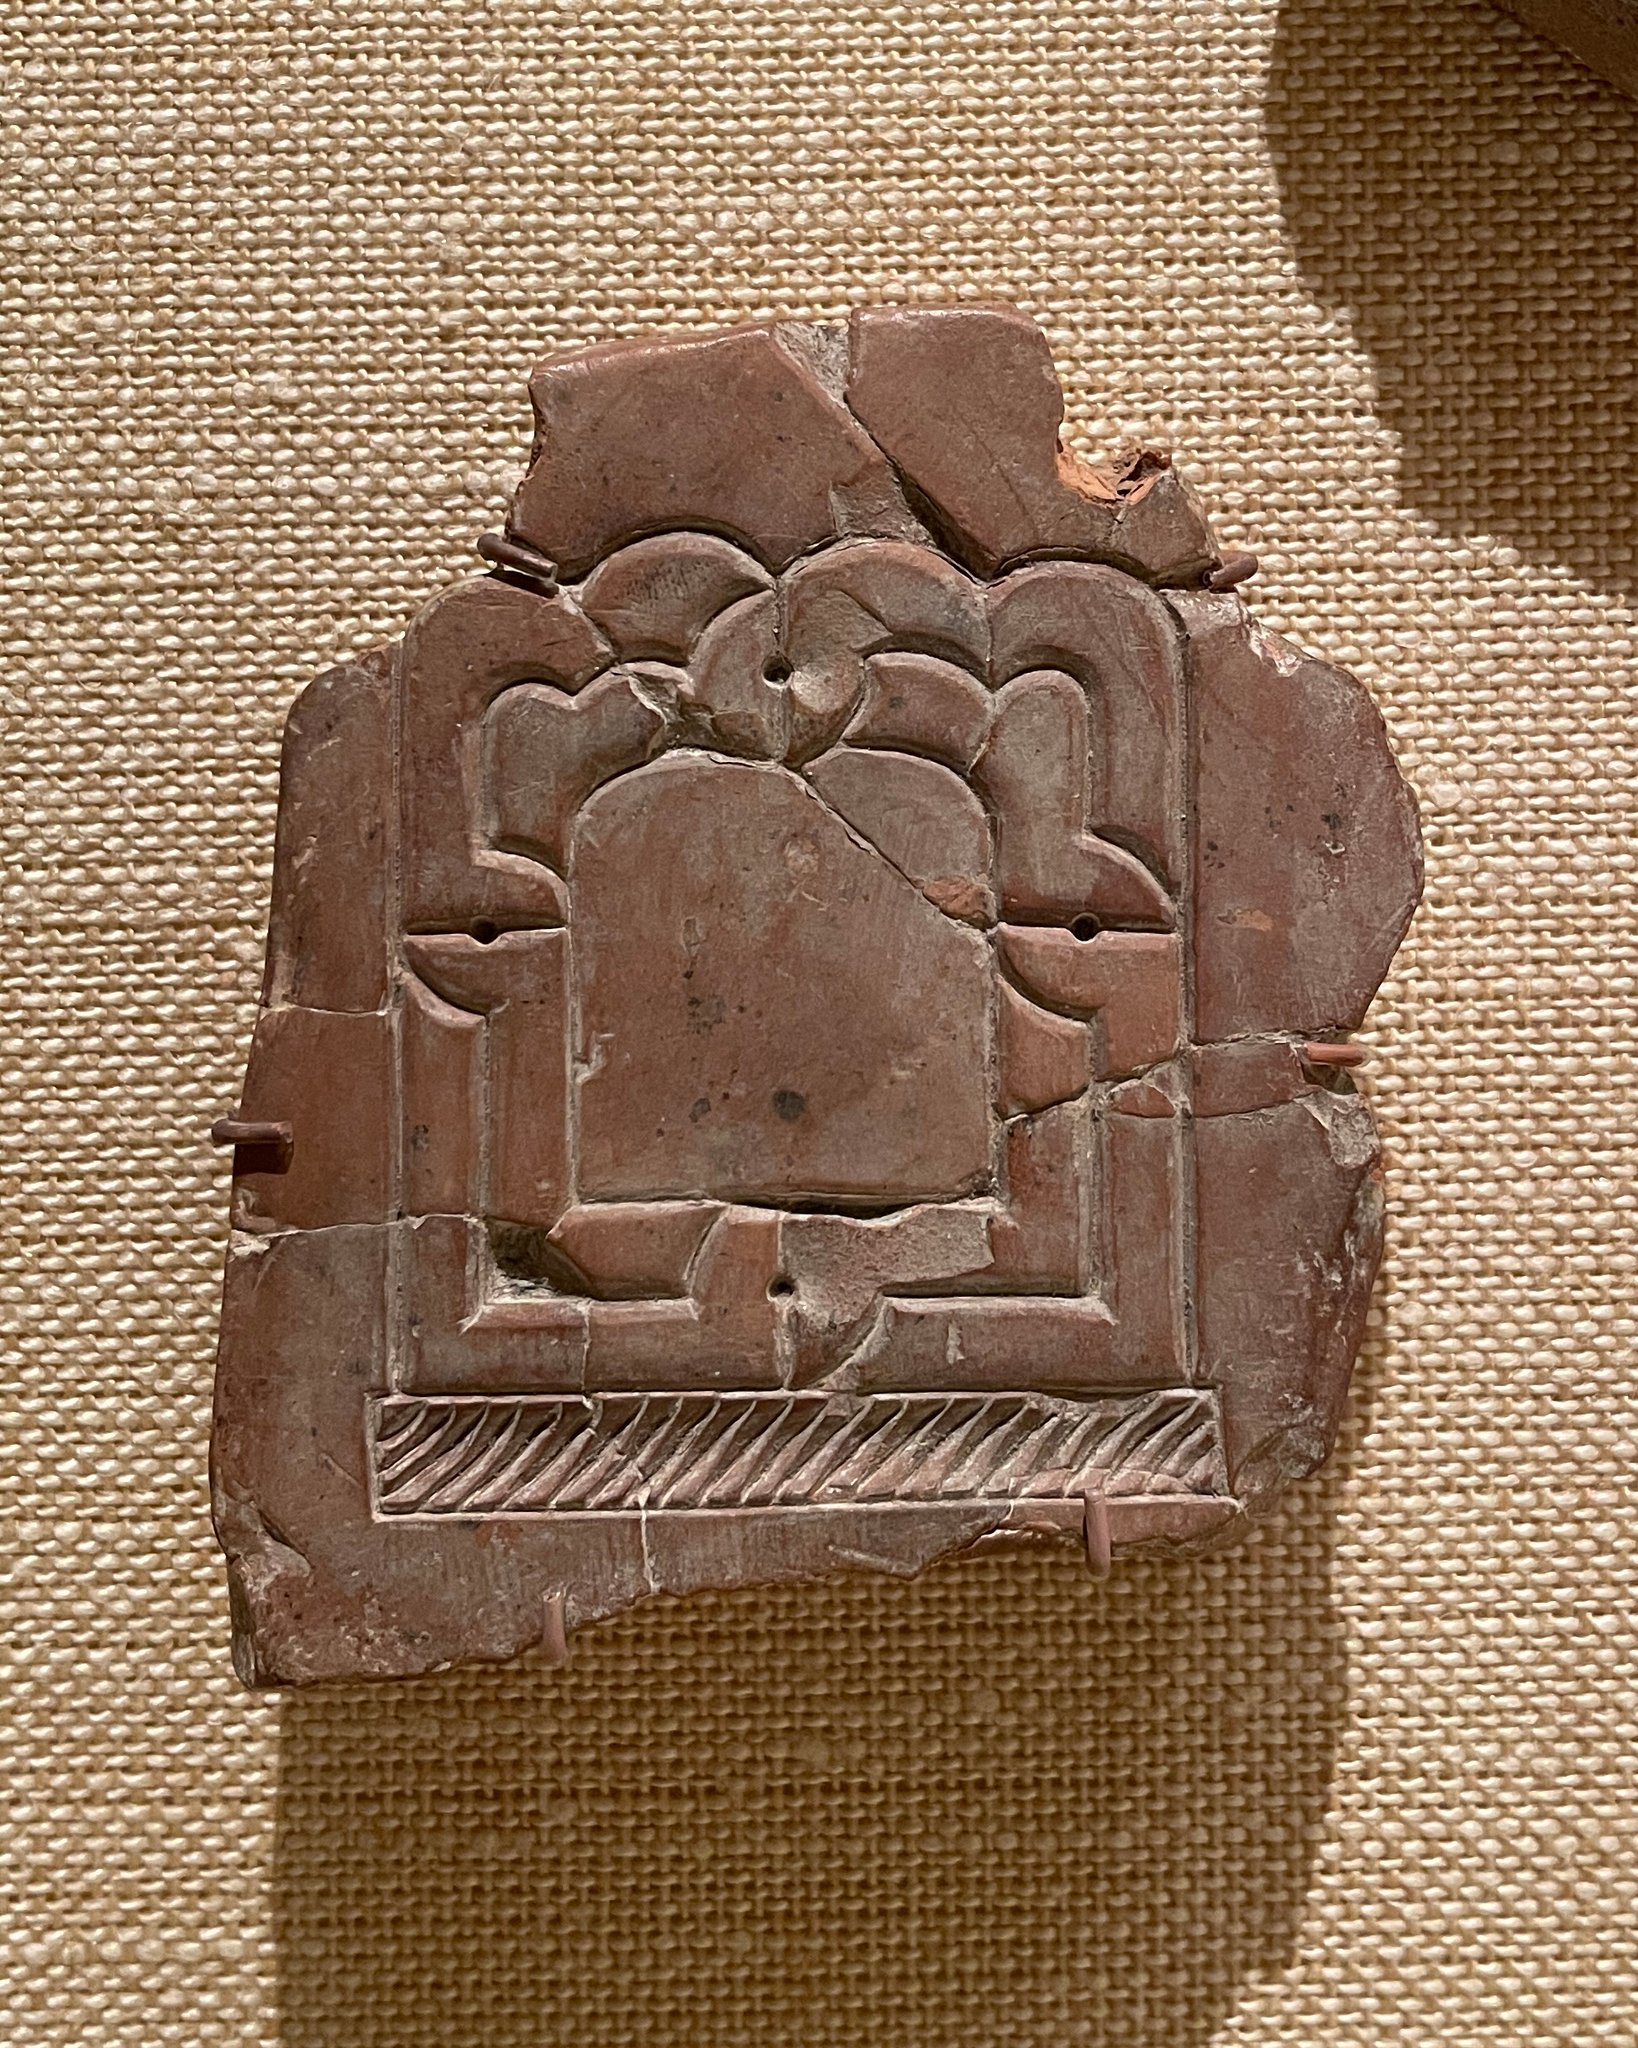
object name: mold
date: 867-933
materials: clay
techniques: molding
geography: iran